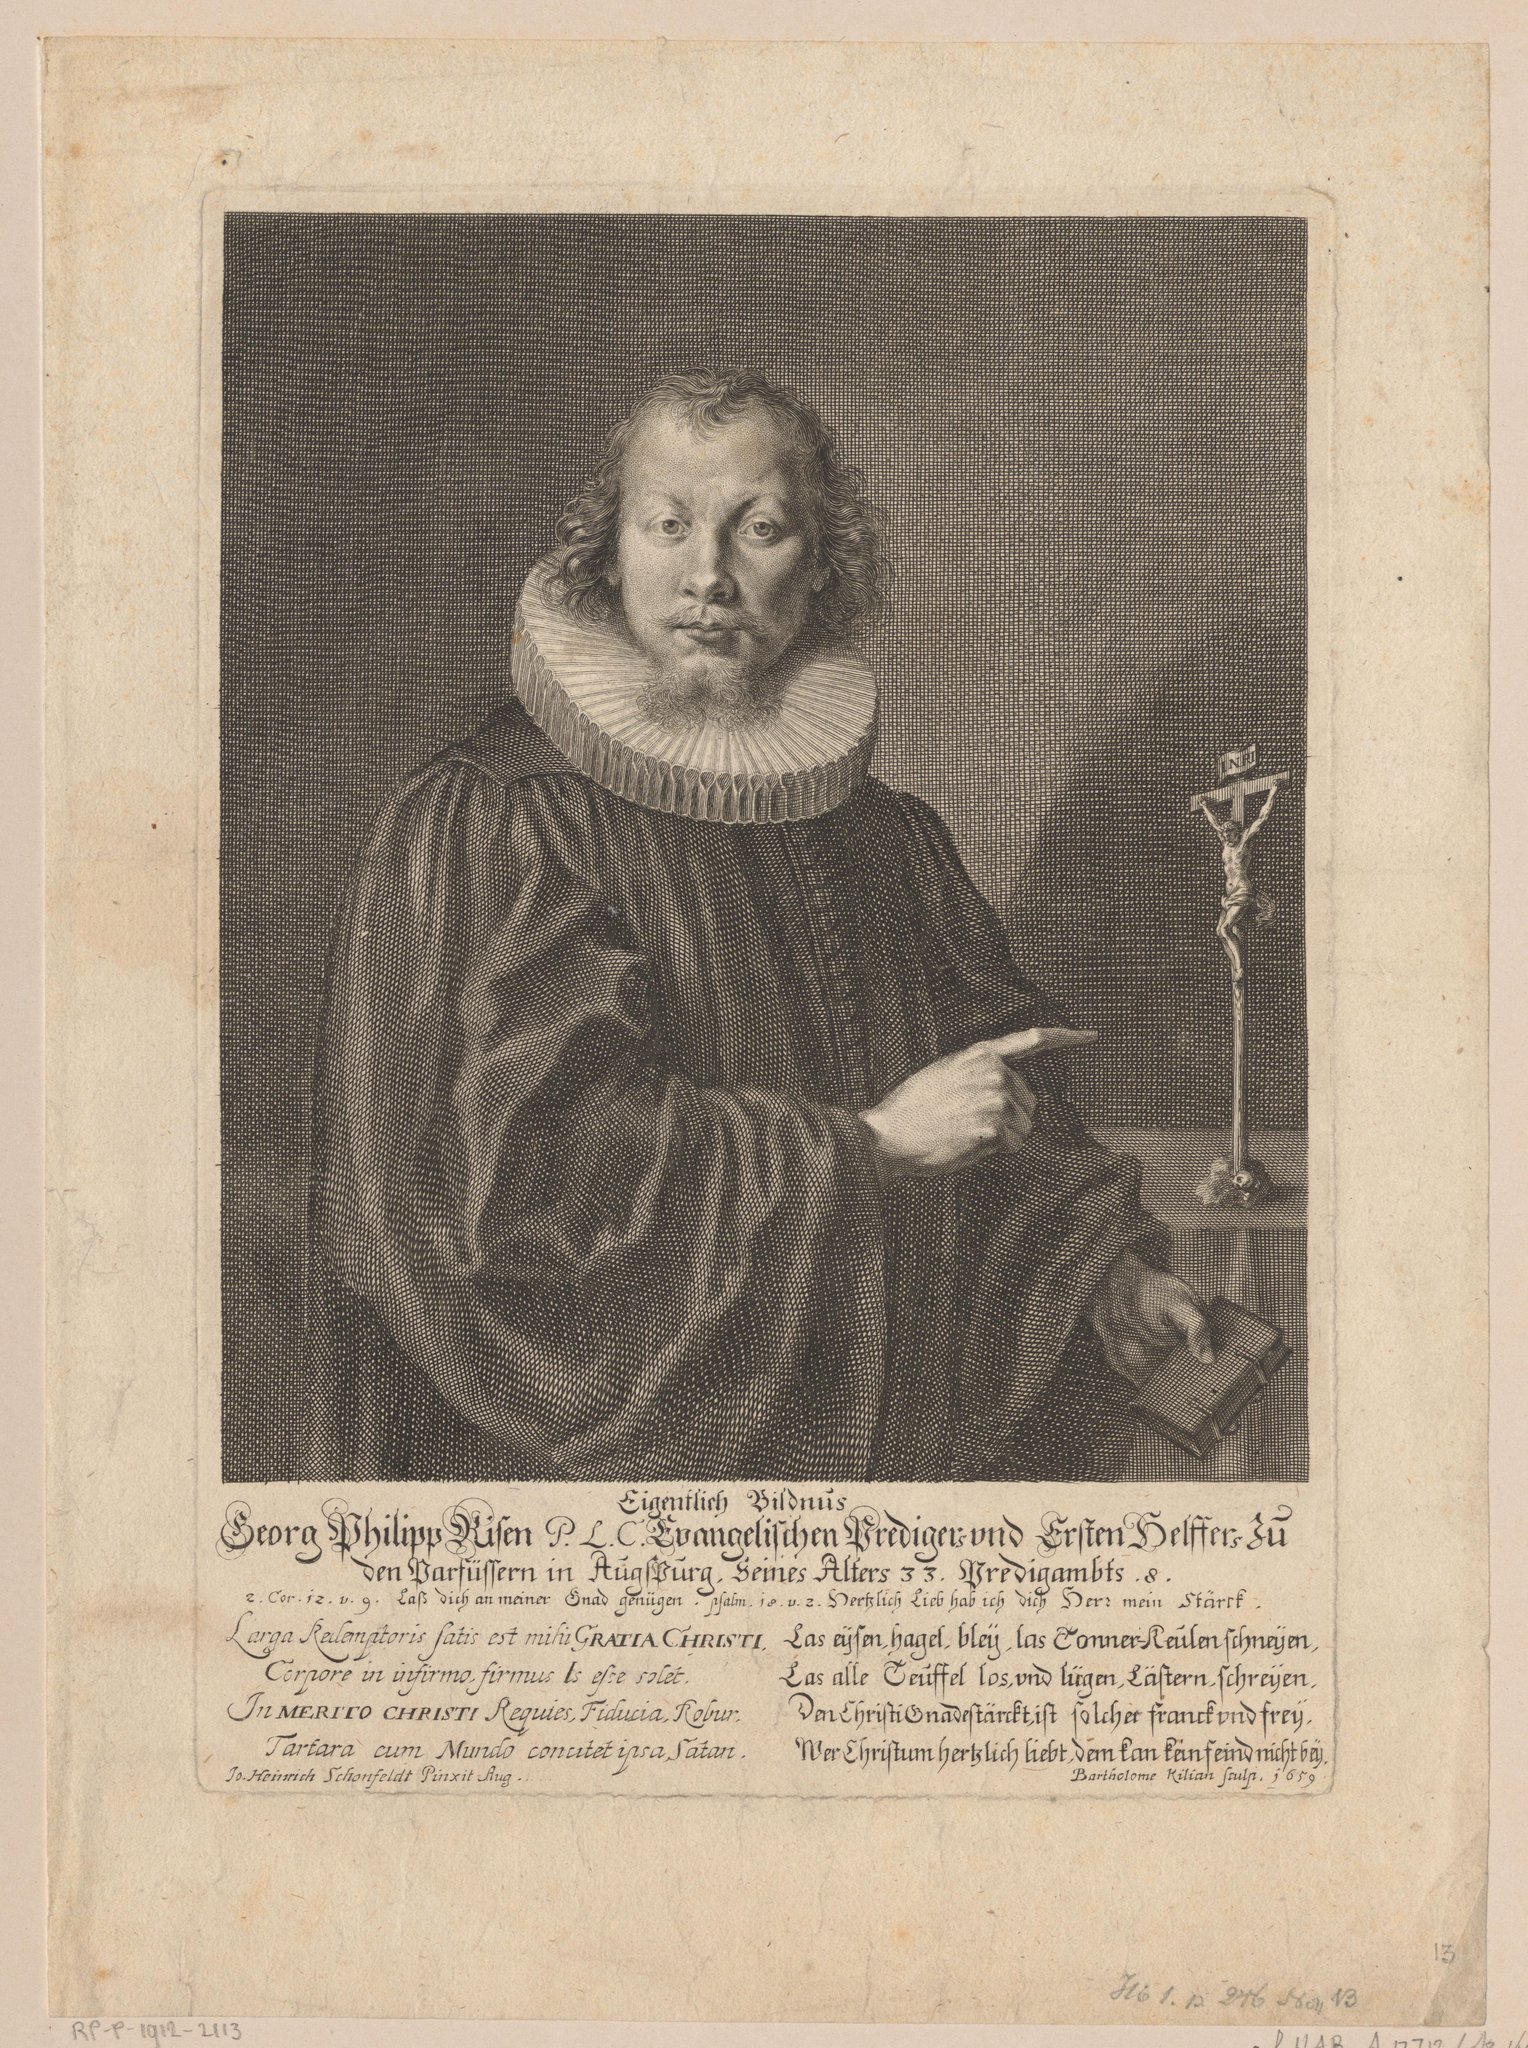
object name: print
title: Portret van Georg Philipp Ris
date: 1659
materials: paper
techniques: engraving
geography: augsburg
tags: georg philipp ris, historical persons, the cross ~ symbols of christ, book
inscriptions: collector's mark: Lugt 2228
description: Onder het portret een vierregelig vers in het Duits en Latijn.